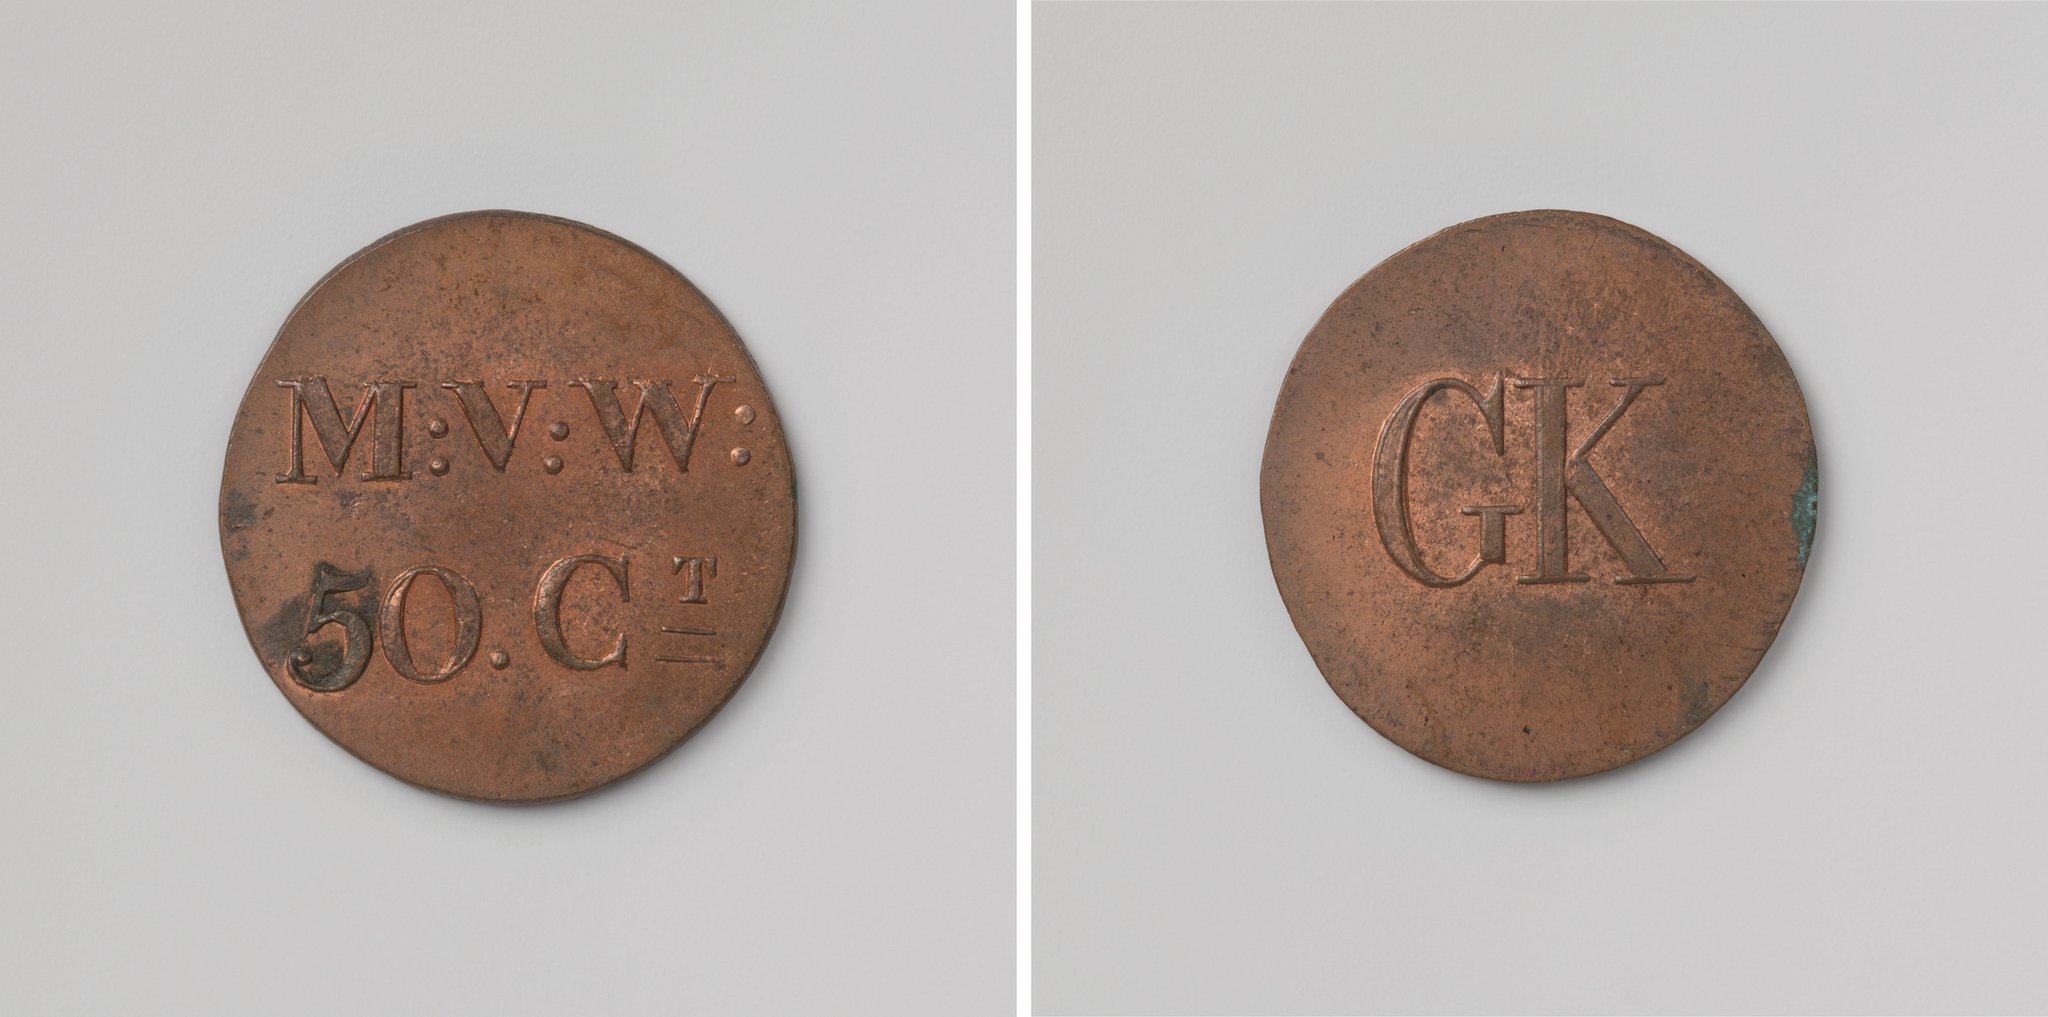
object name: vijftig cent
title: Huismunt geslagen op last van de Maatschappij van Weldadigheid ter waarde van 50 cent, ten behoeve van de Gewone Koloniën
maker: Anonymous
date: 1818-1859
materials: copper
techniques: striking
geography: netherlands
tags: maatschappij van weldadigheid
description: Voorzijde: opschrift boven waardeaanduiding. Keerzijde: opschrift G en K